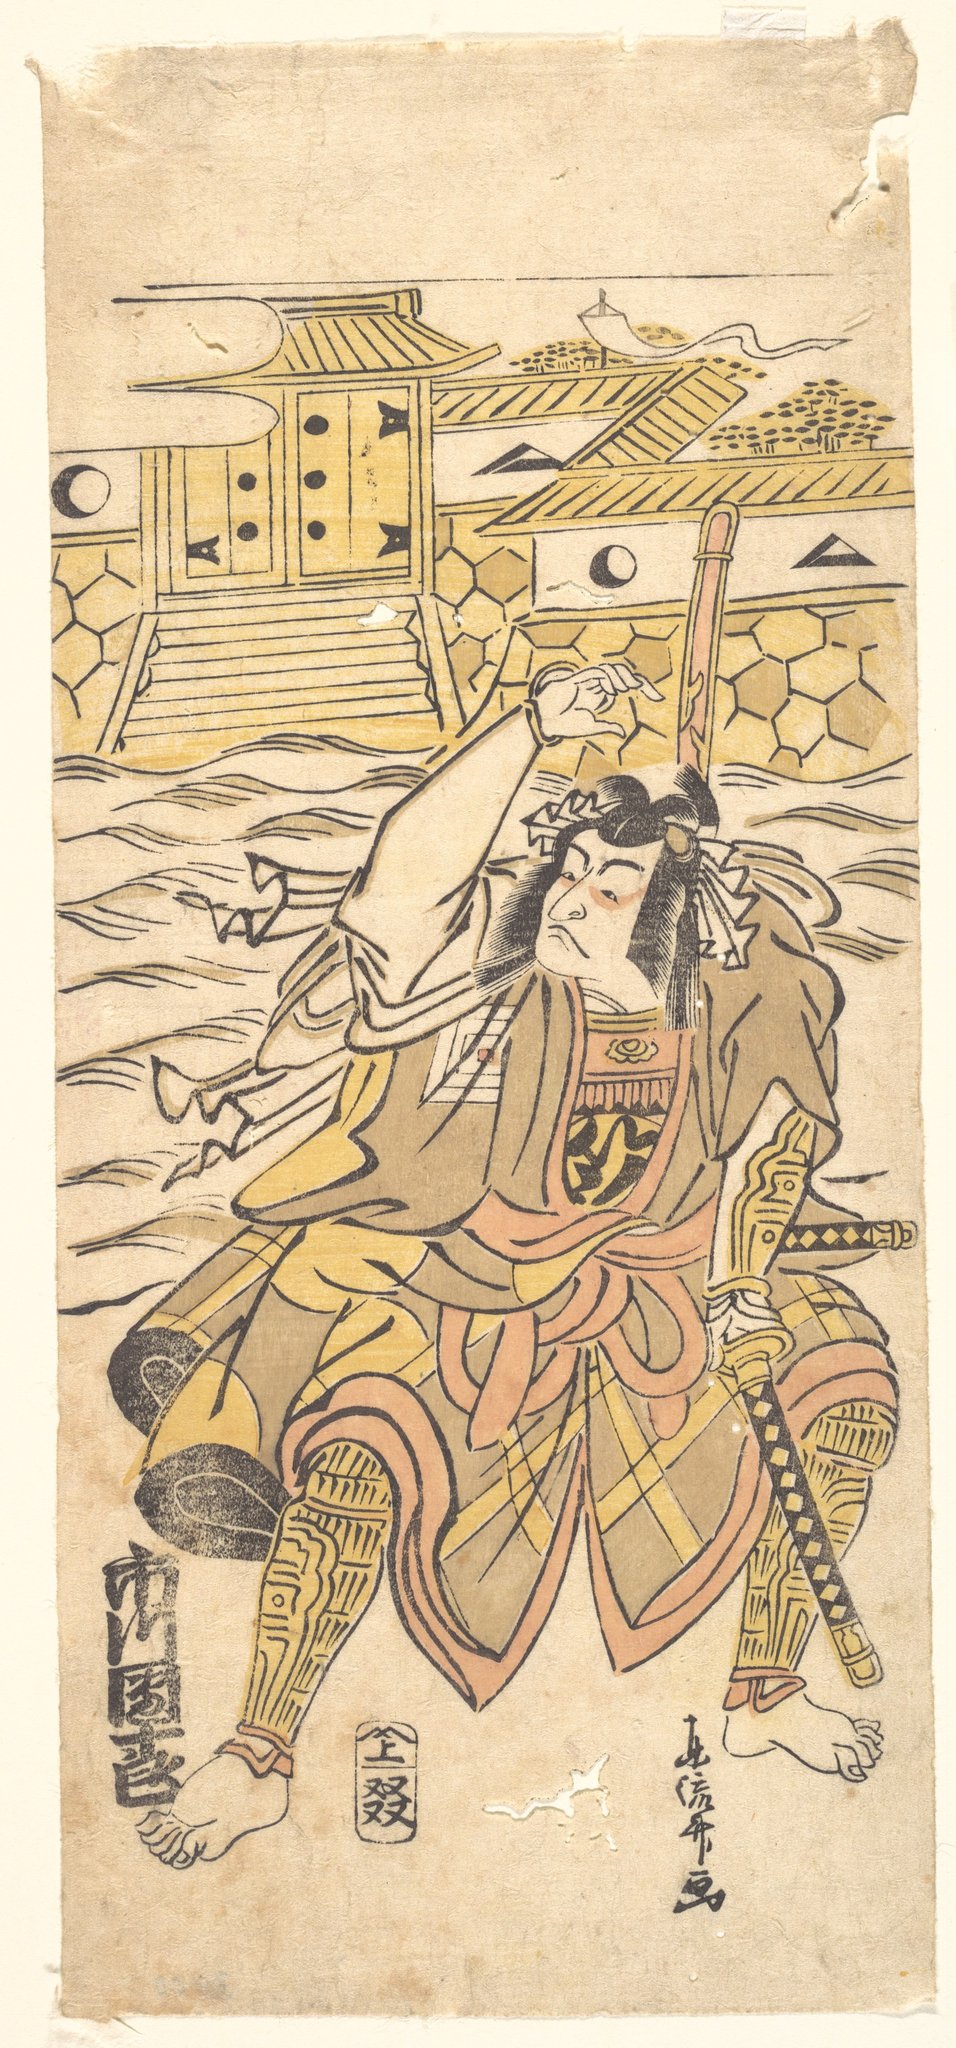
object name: print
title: Actor, Danjuro, Impersonating Murubashi Chuye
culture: japanese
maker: toryusai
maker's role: artist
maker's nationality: japanese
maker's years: 1785-1800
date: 1785-1800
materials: ink, paper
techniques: woodblock print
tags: men,actors